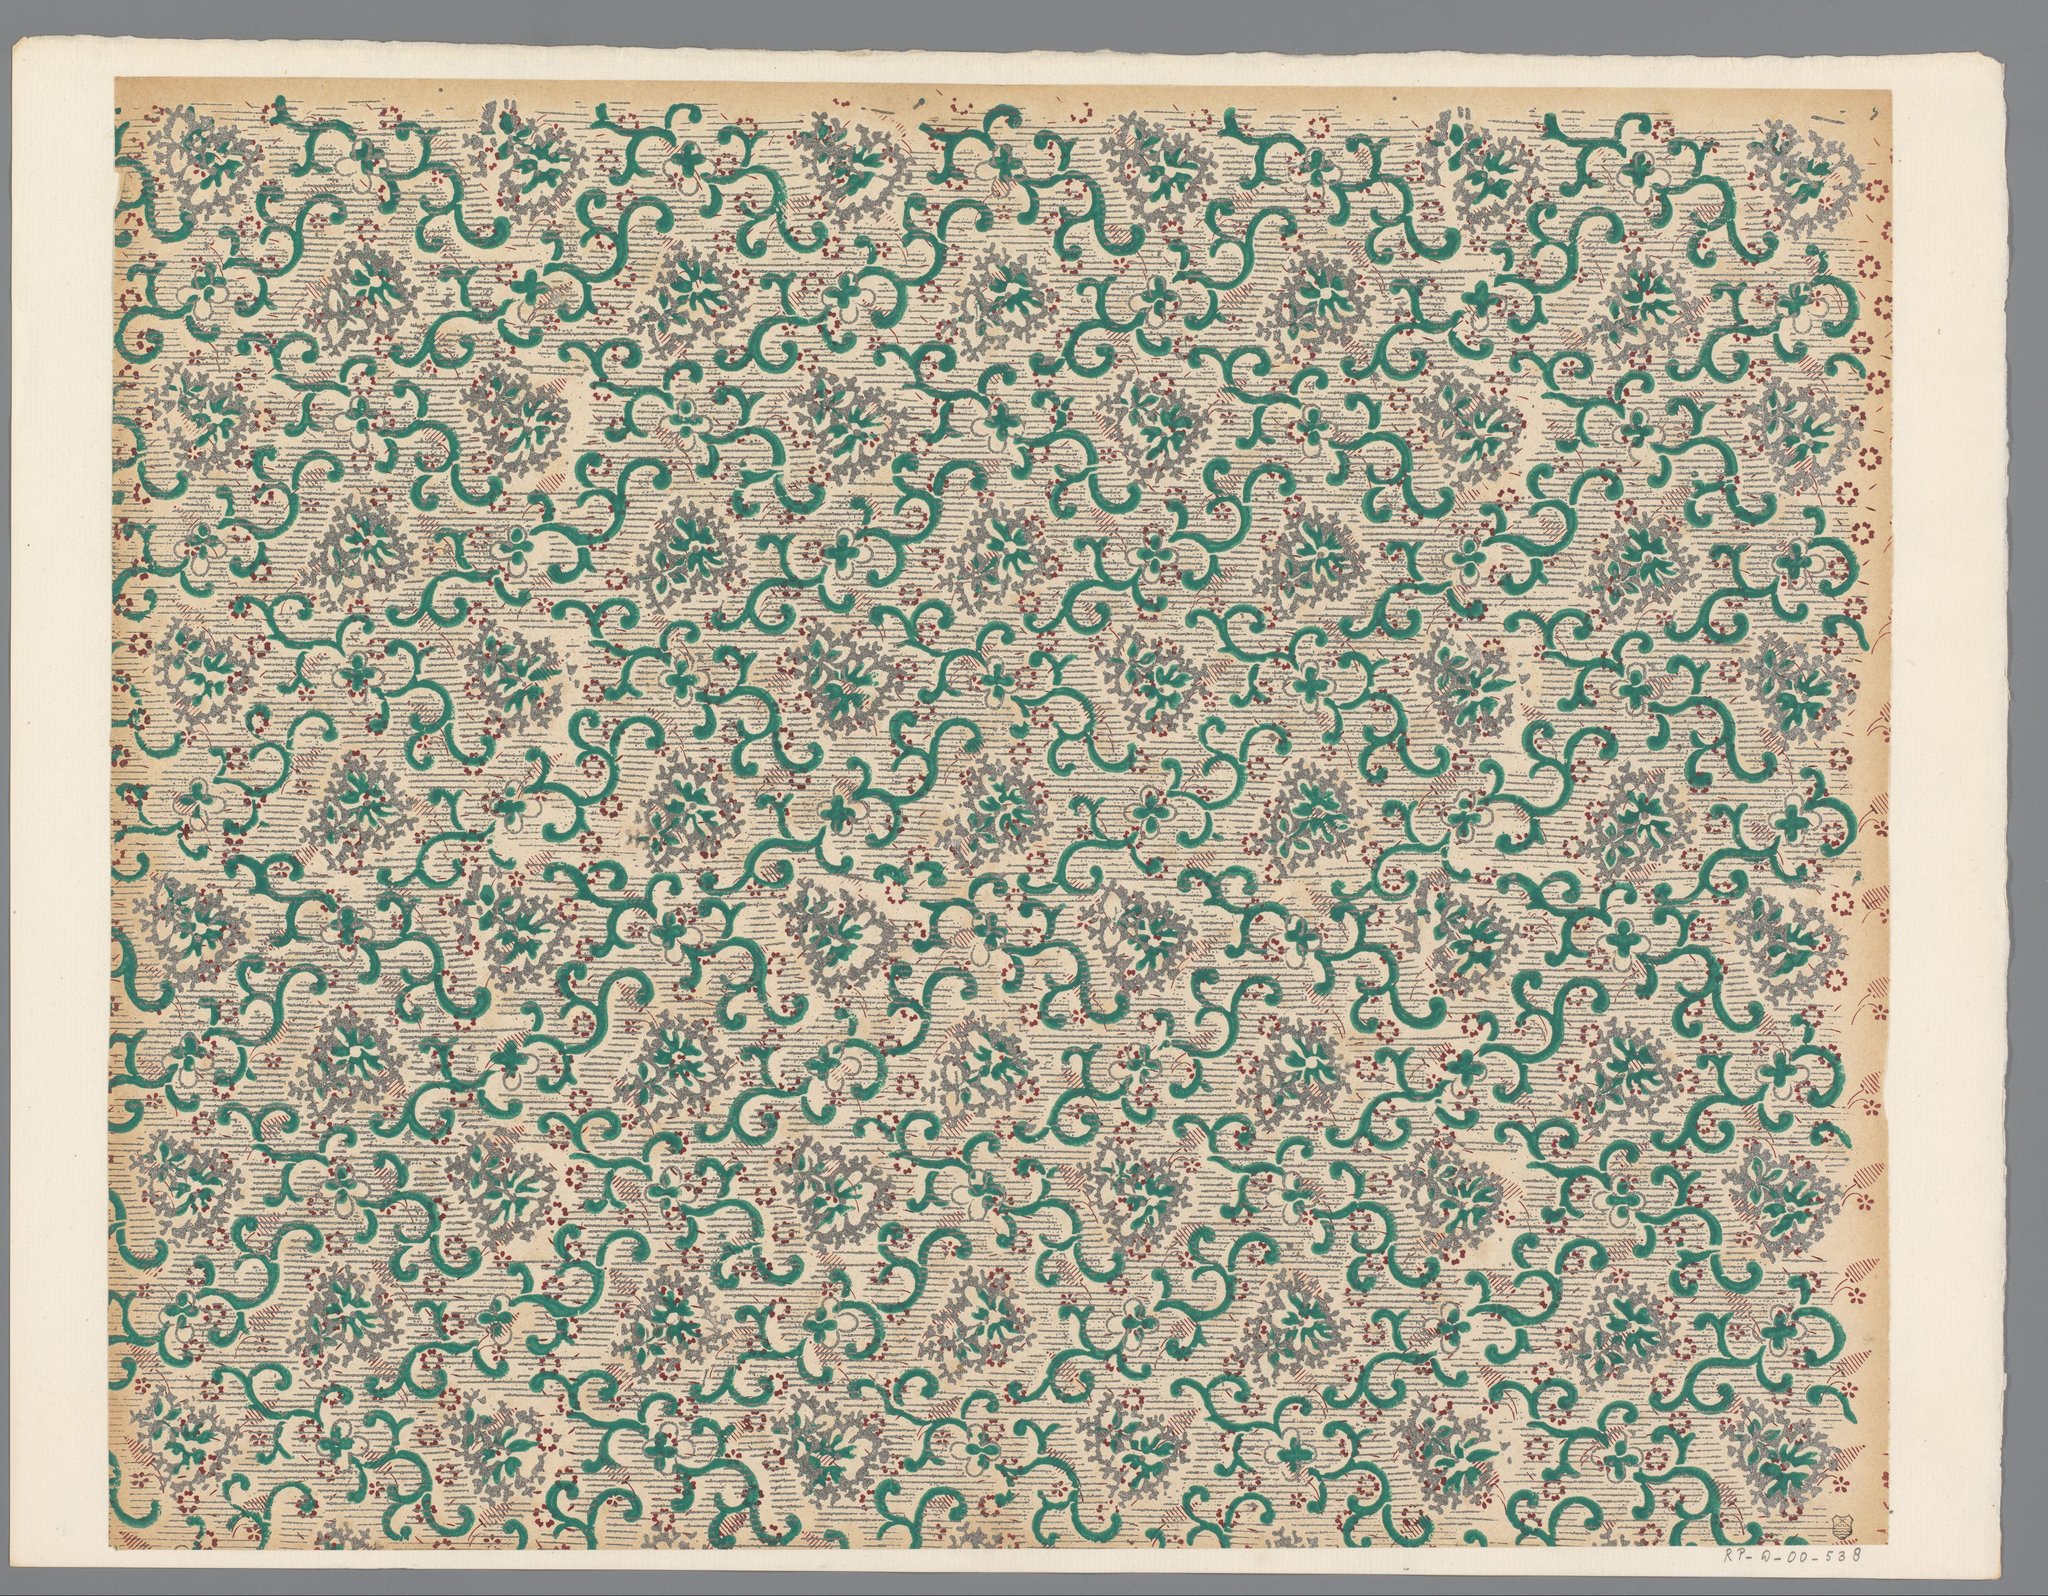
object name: printed paper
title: Blad met strooipatroon van ranken en bloemen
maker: Anonymous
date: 1800-1900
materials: paper, paint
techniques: printing block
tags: ornament derived from plant forms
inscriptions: collector's mark: Lugt 2760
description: Blad met strooipatroon van gestileerde ranken over verschillende bloemen.